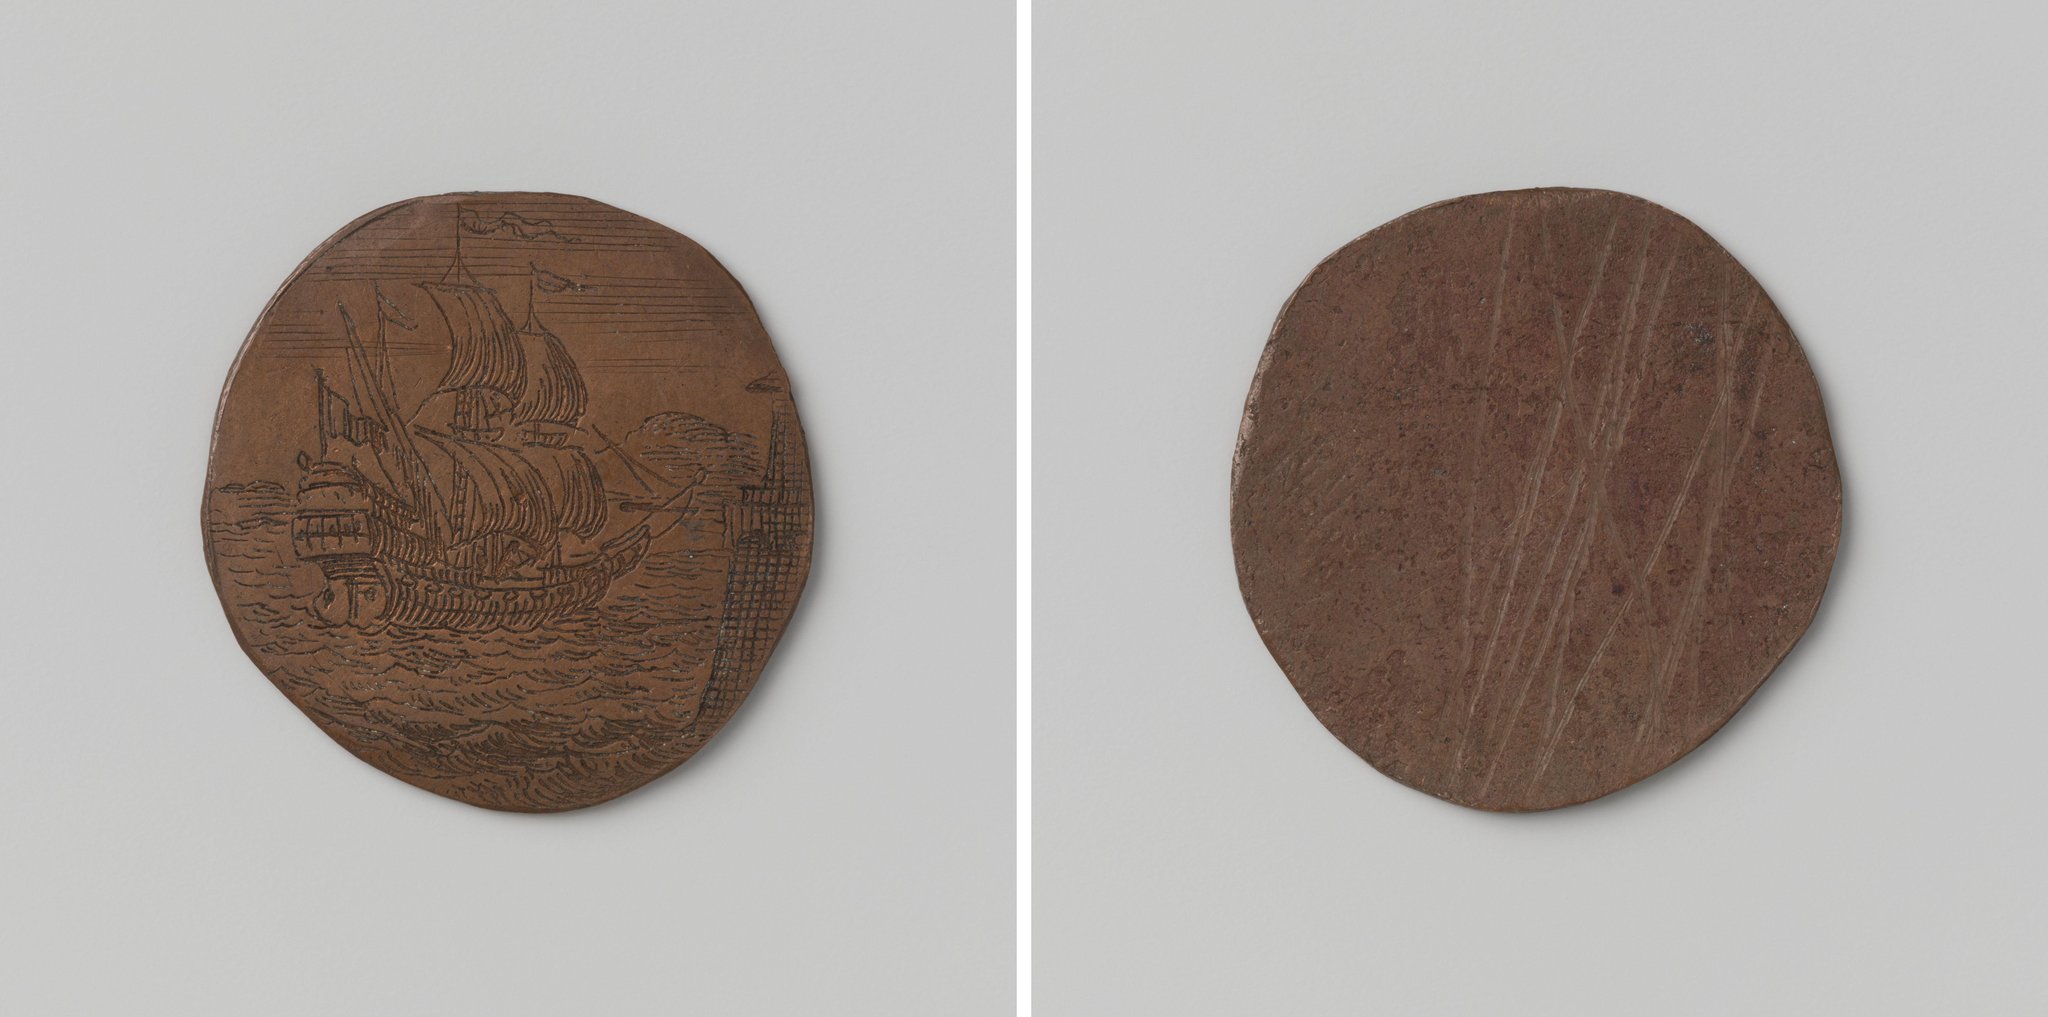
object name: medal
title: Varende driemaster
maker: Anonymous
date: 1600-1700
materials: copper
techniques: engraving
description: Eenzijdig gegraveerde koperen bijna ronde penning. Voorzijde: naar rechts varende driemaster; rechts: toren, op achtergrond: een heuvel. Keerzijde: blanco.